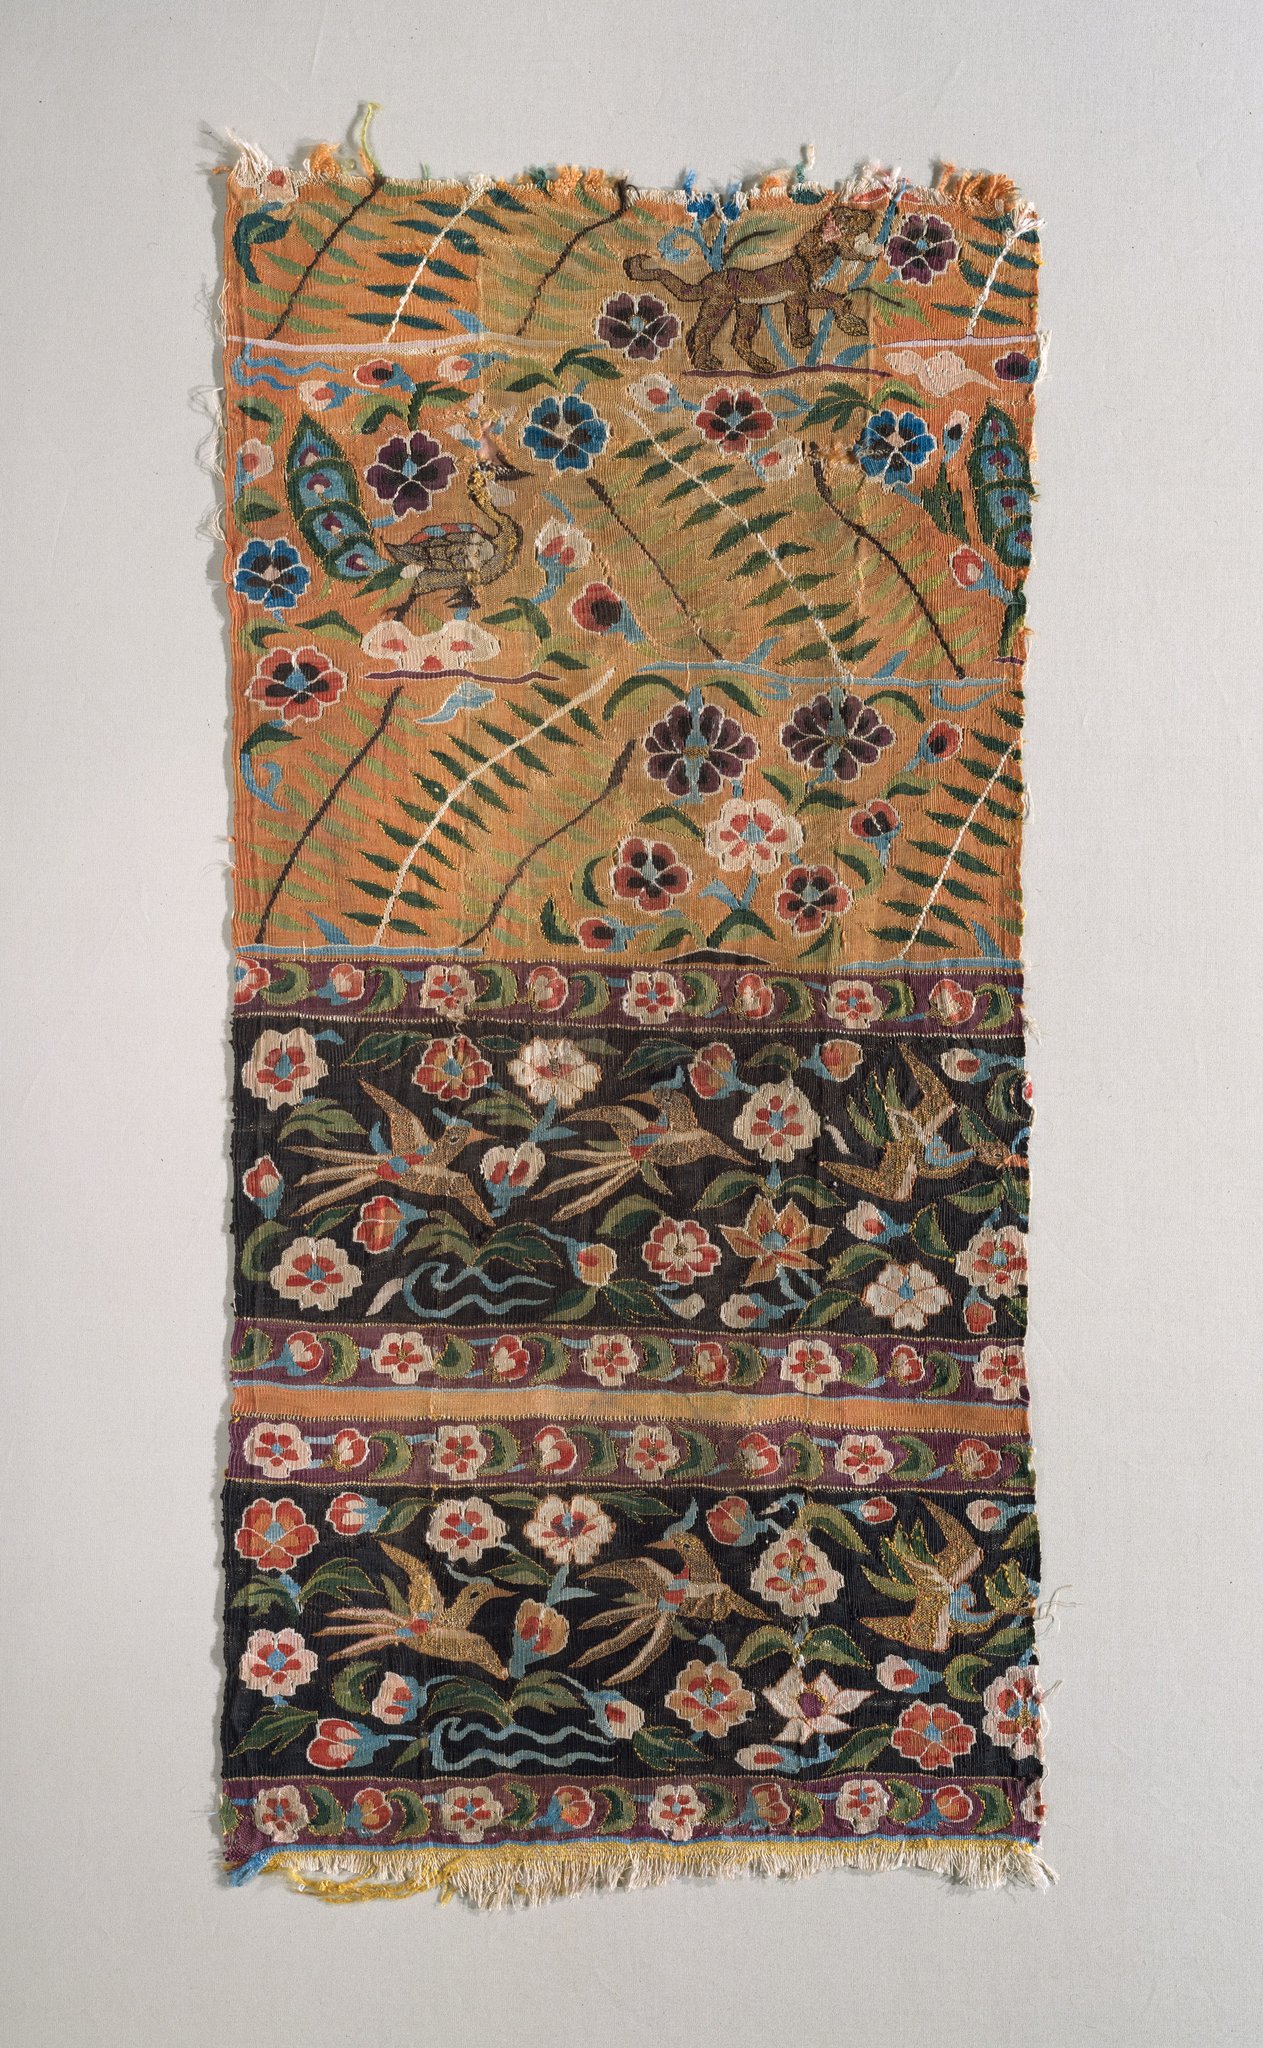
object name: kesi panel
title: Panel with Tiger and Birds on Floral Ground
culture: eastern central asian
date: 901-1200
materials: metal thread, silk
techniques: tapestry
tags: birds,tigers,flowers